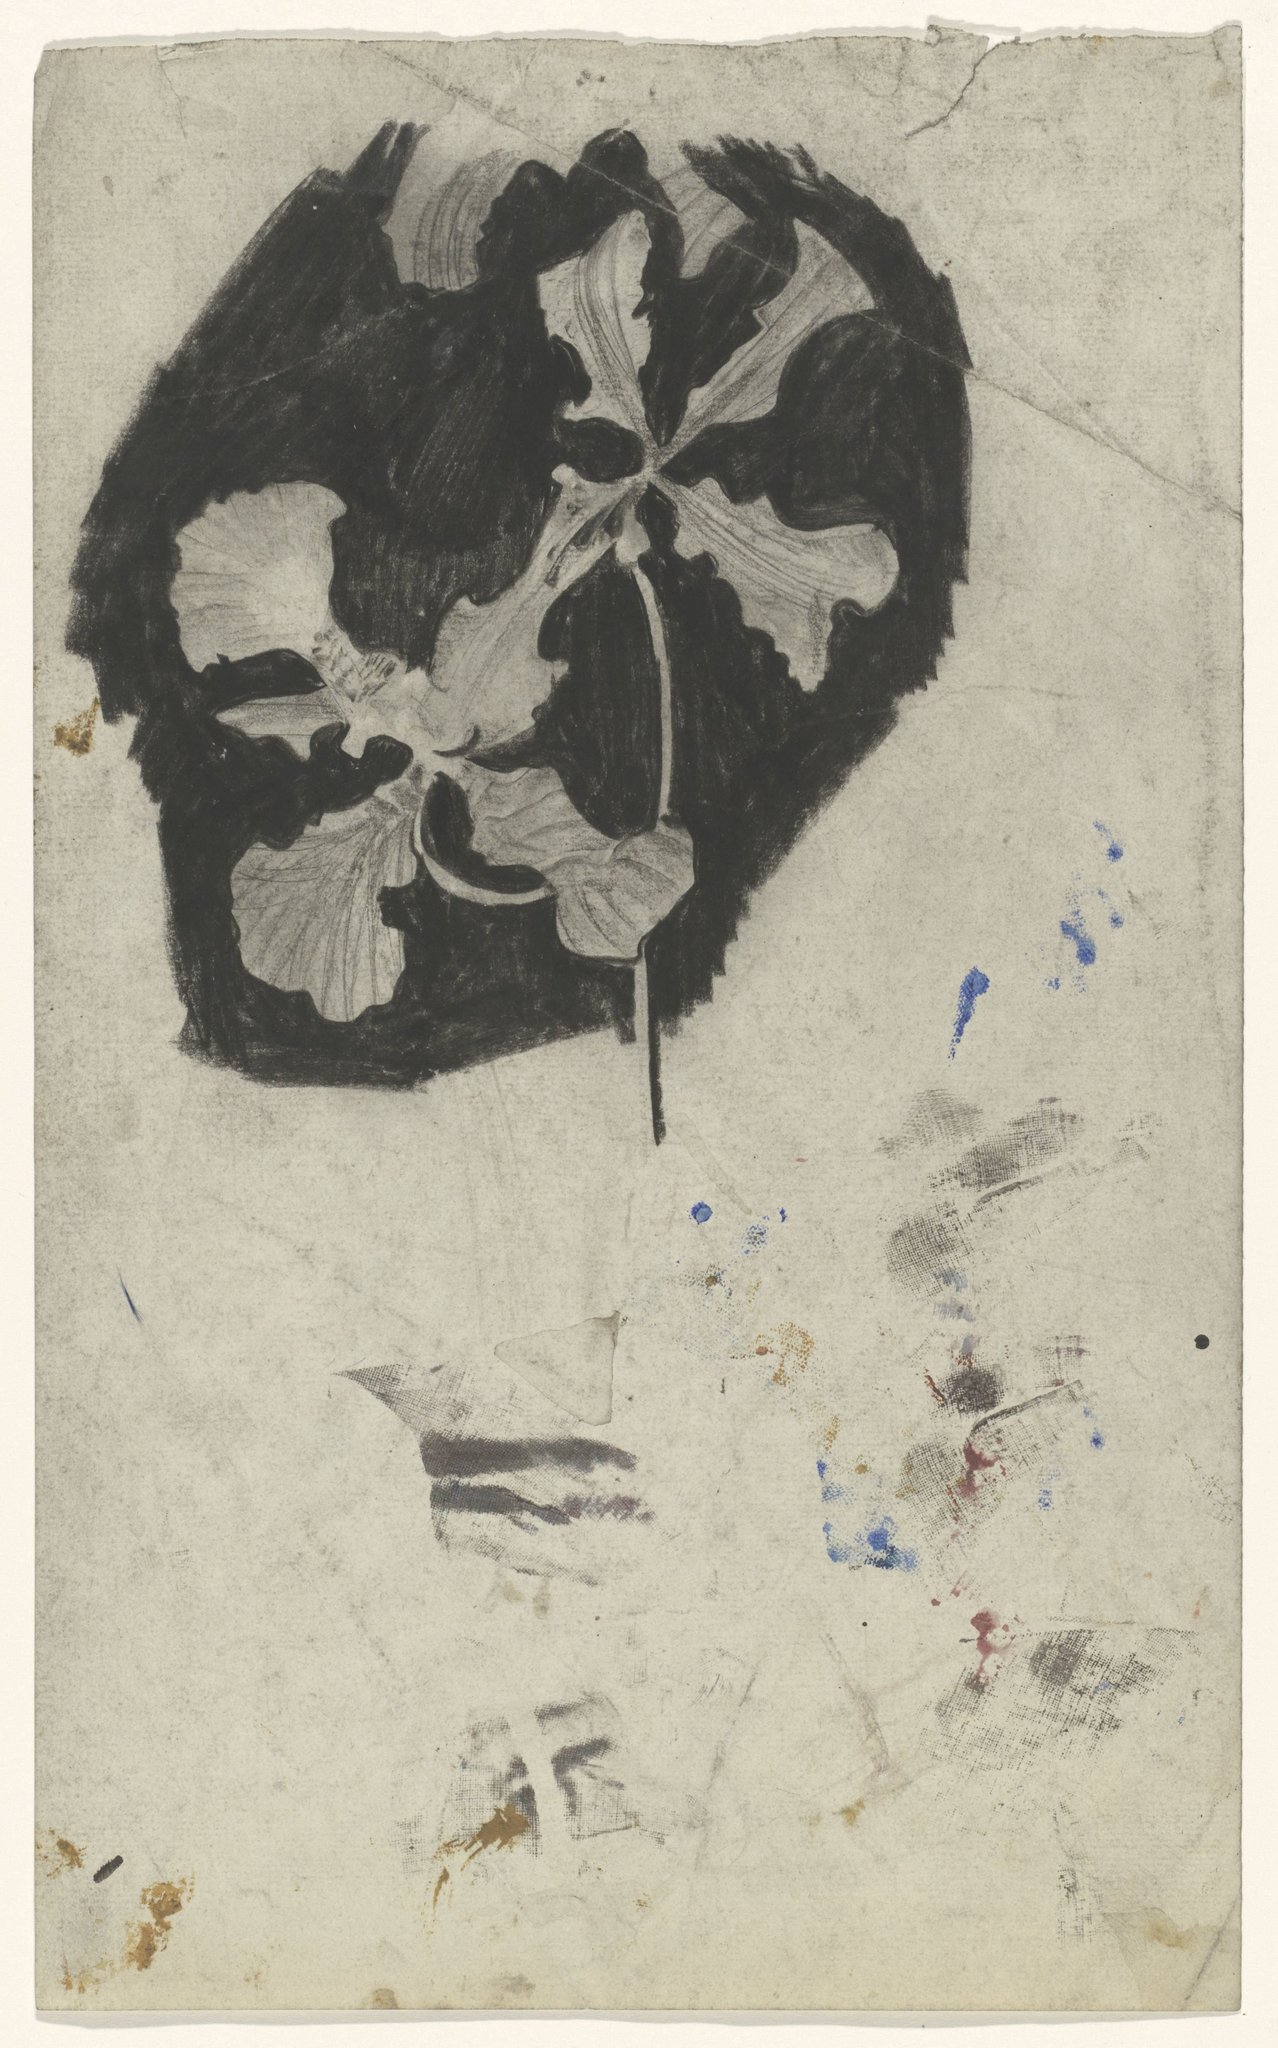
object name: drawing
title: Tak orchideeën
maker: carel adolph lion cachet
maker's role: draughtsman, print maker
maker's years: 1864-1945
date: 1874-1945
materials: charcoal, paper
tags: flowers: orchid